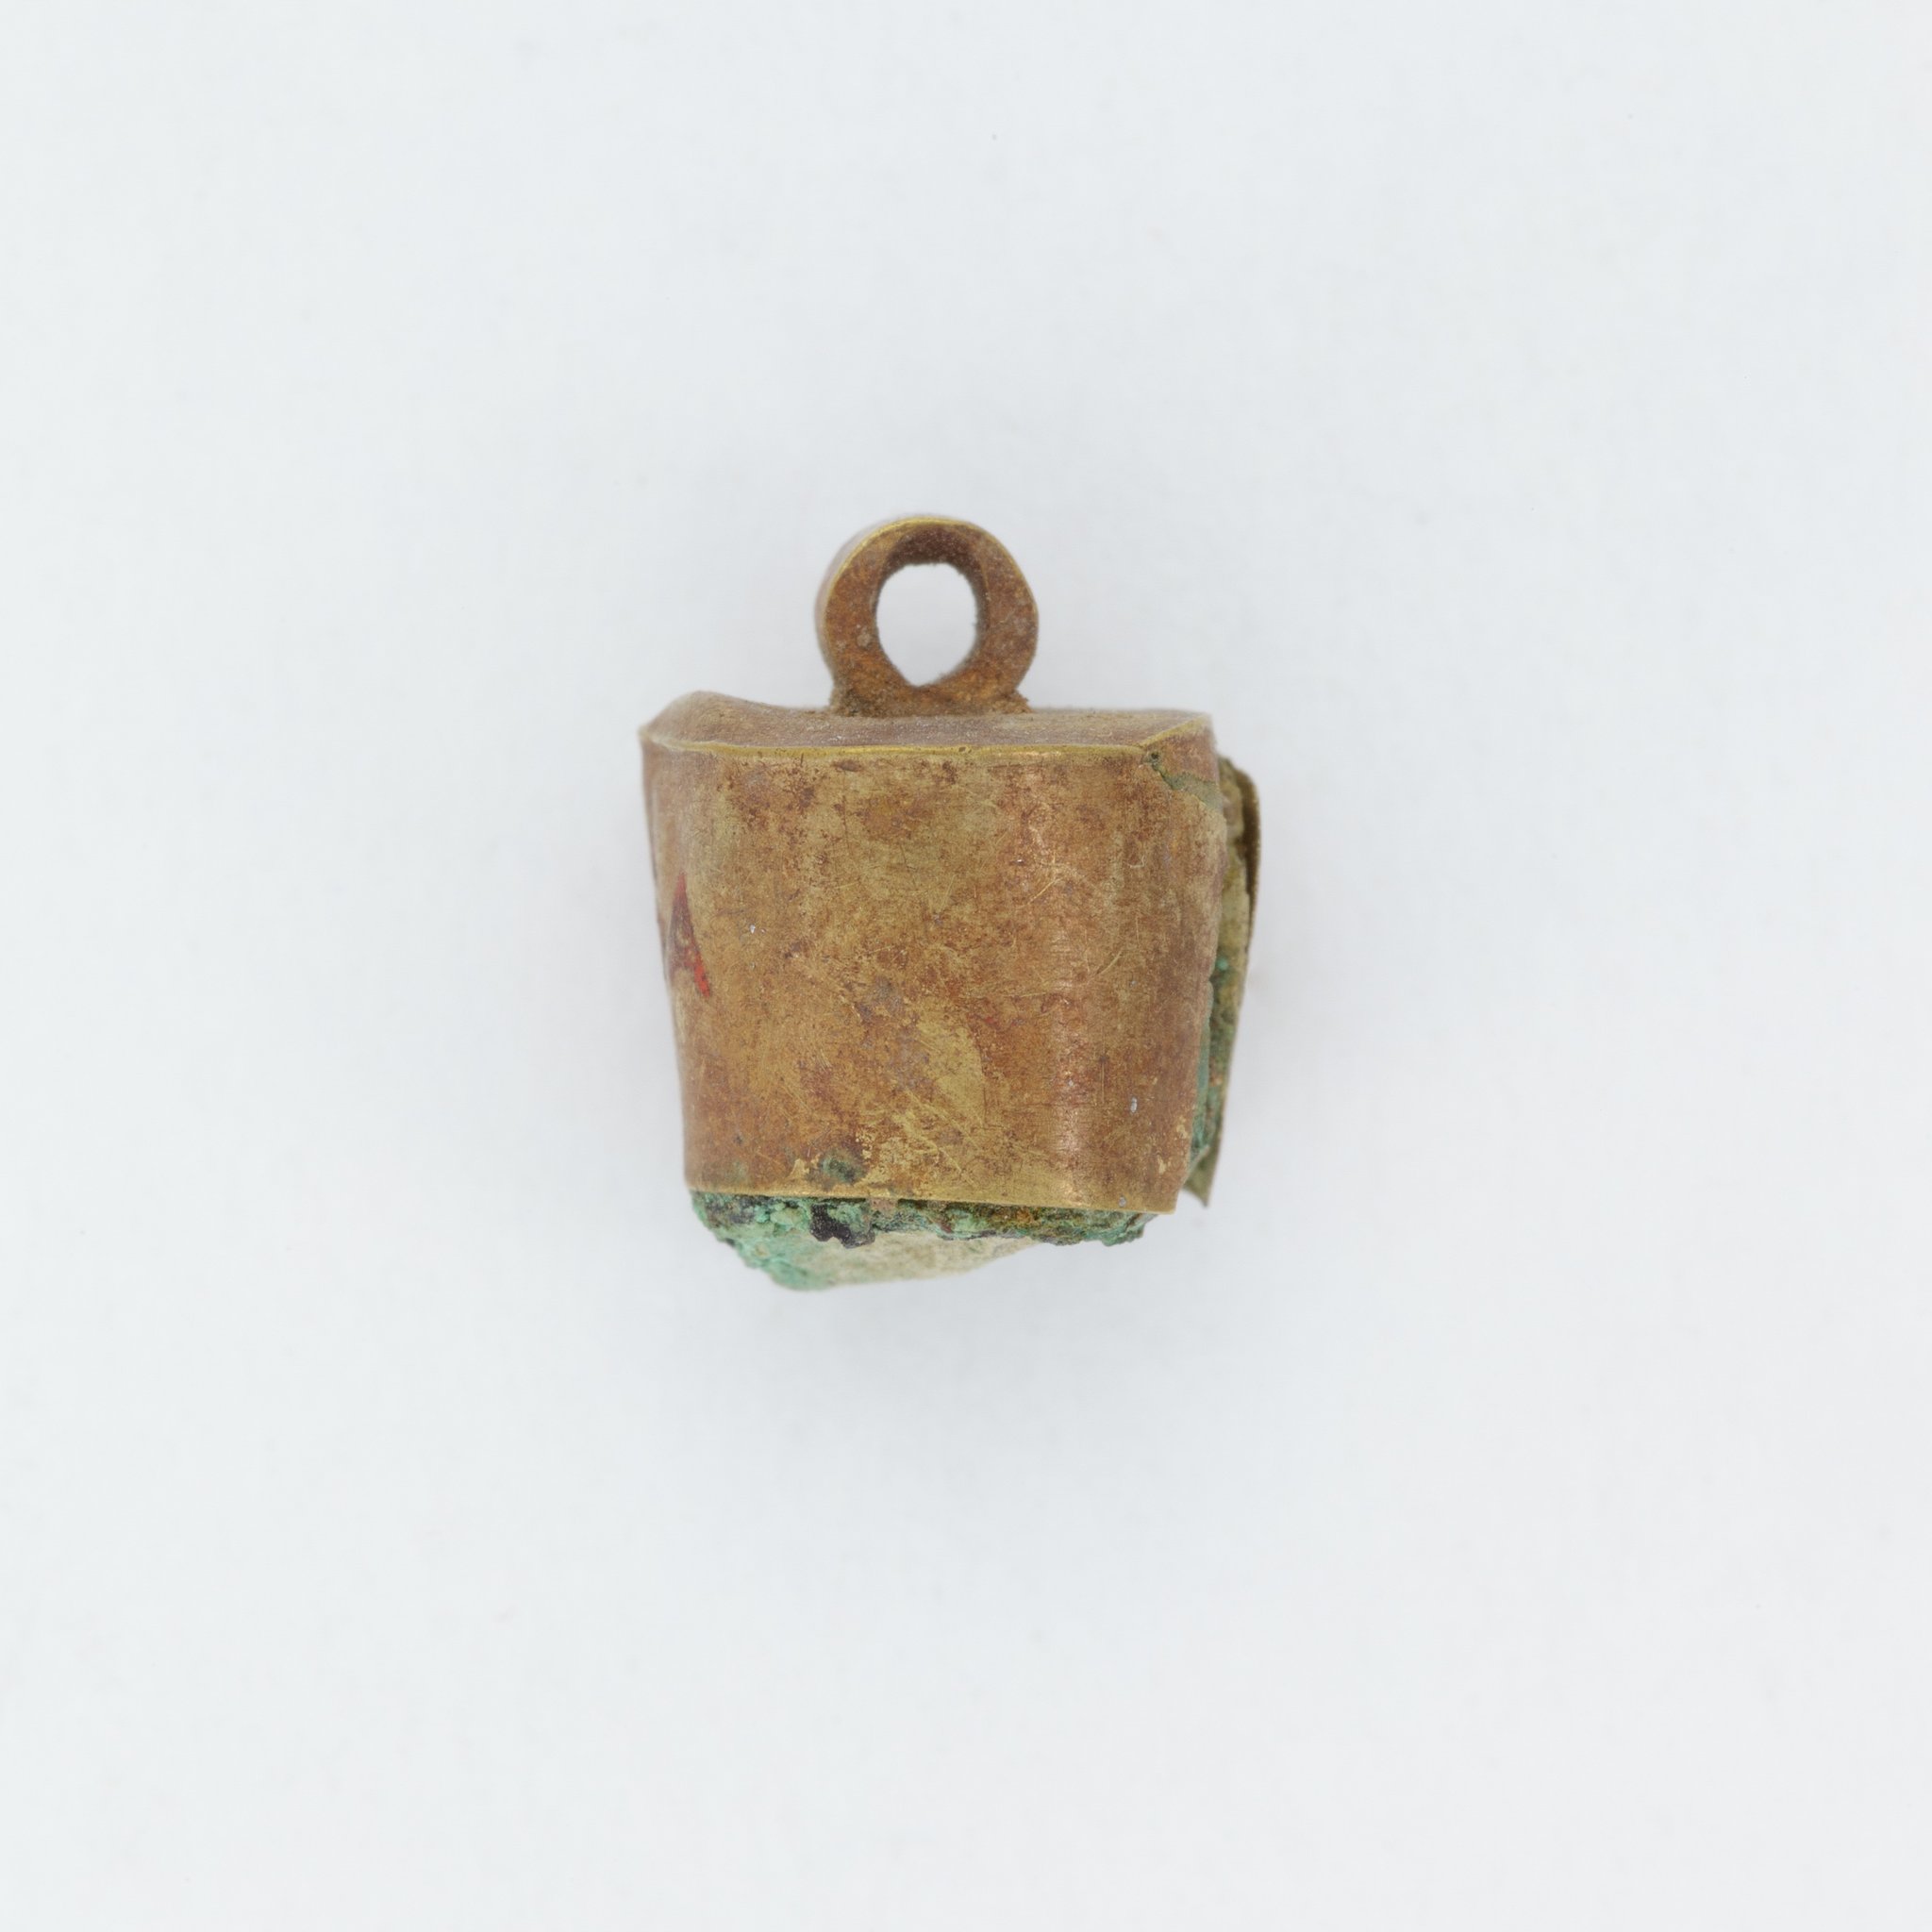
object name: cap, cylindrical pendant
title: Cap probably from a cylindrical pendant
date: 1750 BCE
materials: copper alloy, gold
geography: egypt